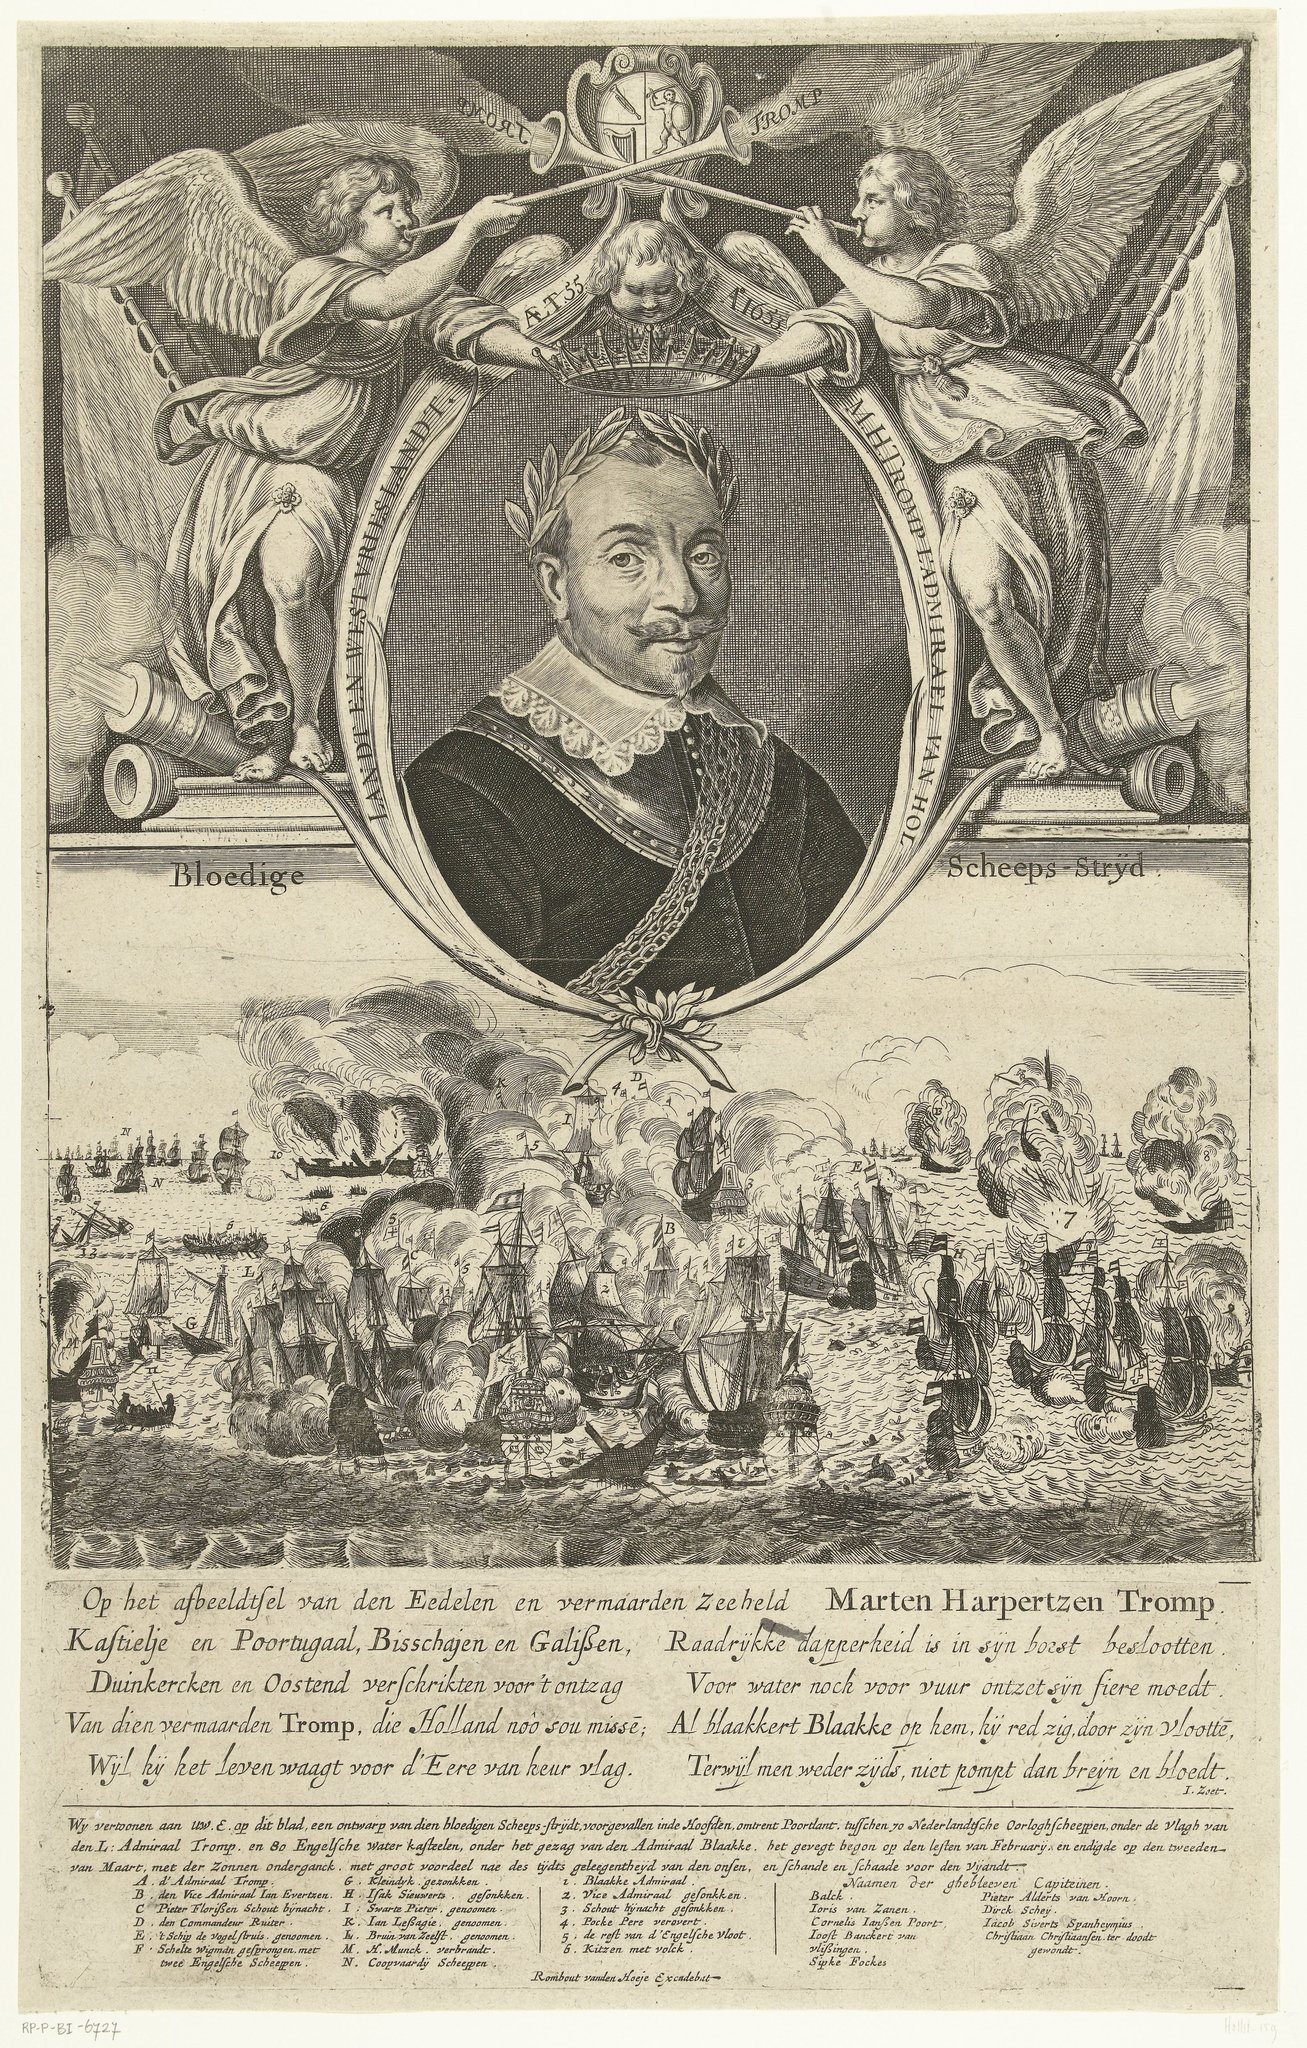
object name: print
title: M.H. Tromp L'admirael van Hollandt en West-Vrieslandt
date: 1640-1653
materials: paper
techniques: engraving, etching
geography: amsterdam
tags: brielle, maarten harpertszoon tromp, commander-in-chief, admiral, battle of portland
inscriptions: collector's mark: Lugt 240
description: Portret van admiraal Maarten Harpertszoon Tromp op 55-jarige leeftijd. De admiraal draagt een lauwerkrans op zijn hoofd. Borststuk in ovale omlijsting geflankeerd door twee engelen die blazen op trompetten en vaandels en rokende kanonnen. Onder het portret een scene uit de driedaagse zeeslag bij Portland uit 1652 met kanonvuur over en weer. In de marge onder een Nederlands vers in acht regels waarmee Tromp's heldendaden worden geprezen. Een verklarende lijst duidt de strijdende partijen aan, deze is gedrukt met een tweede plaat.